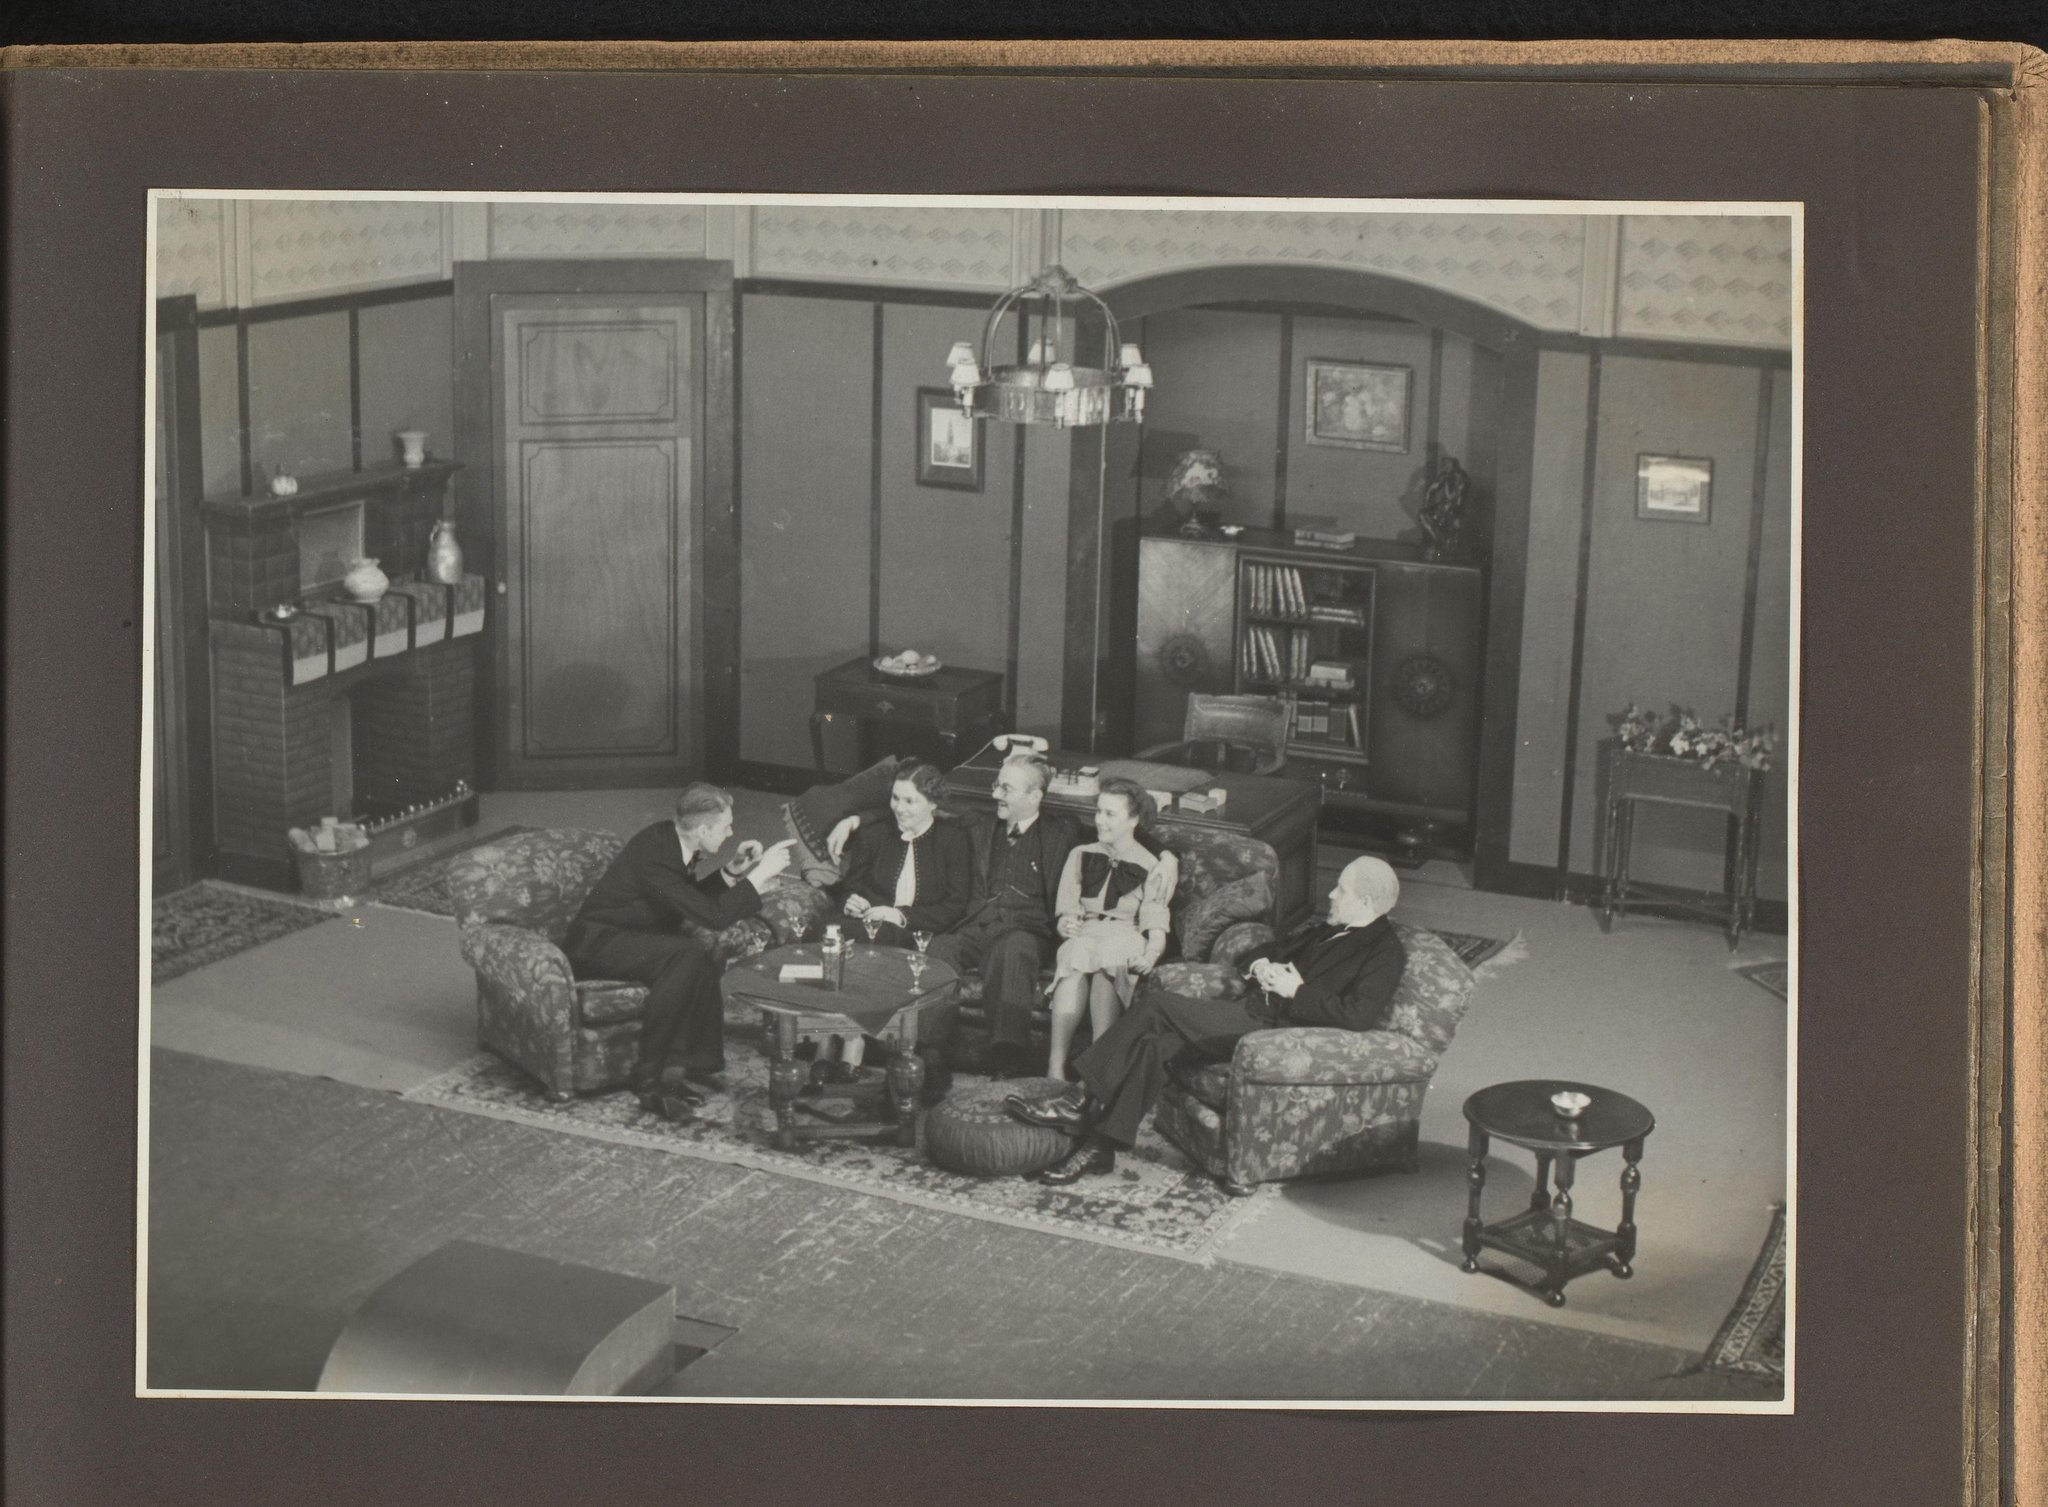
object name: photograph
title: Een scène uit het toneelstuk 'Wat Jonas overkwam'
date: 1936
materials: paper, photographic support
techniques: gelatin silver print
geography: haarlem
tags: theatre, theatrical performance, students' organization, vocational education, e.g.: junior technical school, haarlem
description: Albumblad met een foto van een scène uit de opvoering van het toneelstuk 'Wat Jonas overkwam' op 22 februari 1936. Scène met vijf personen in een huiskamer. Onderdeel van het fotoalbum 'Jaarfeesten van het Corps M.T.S. te Haarlem'.